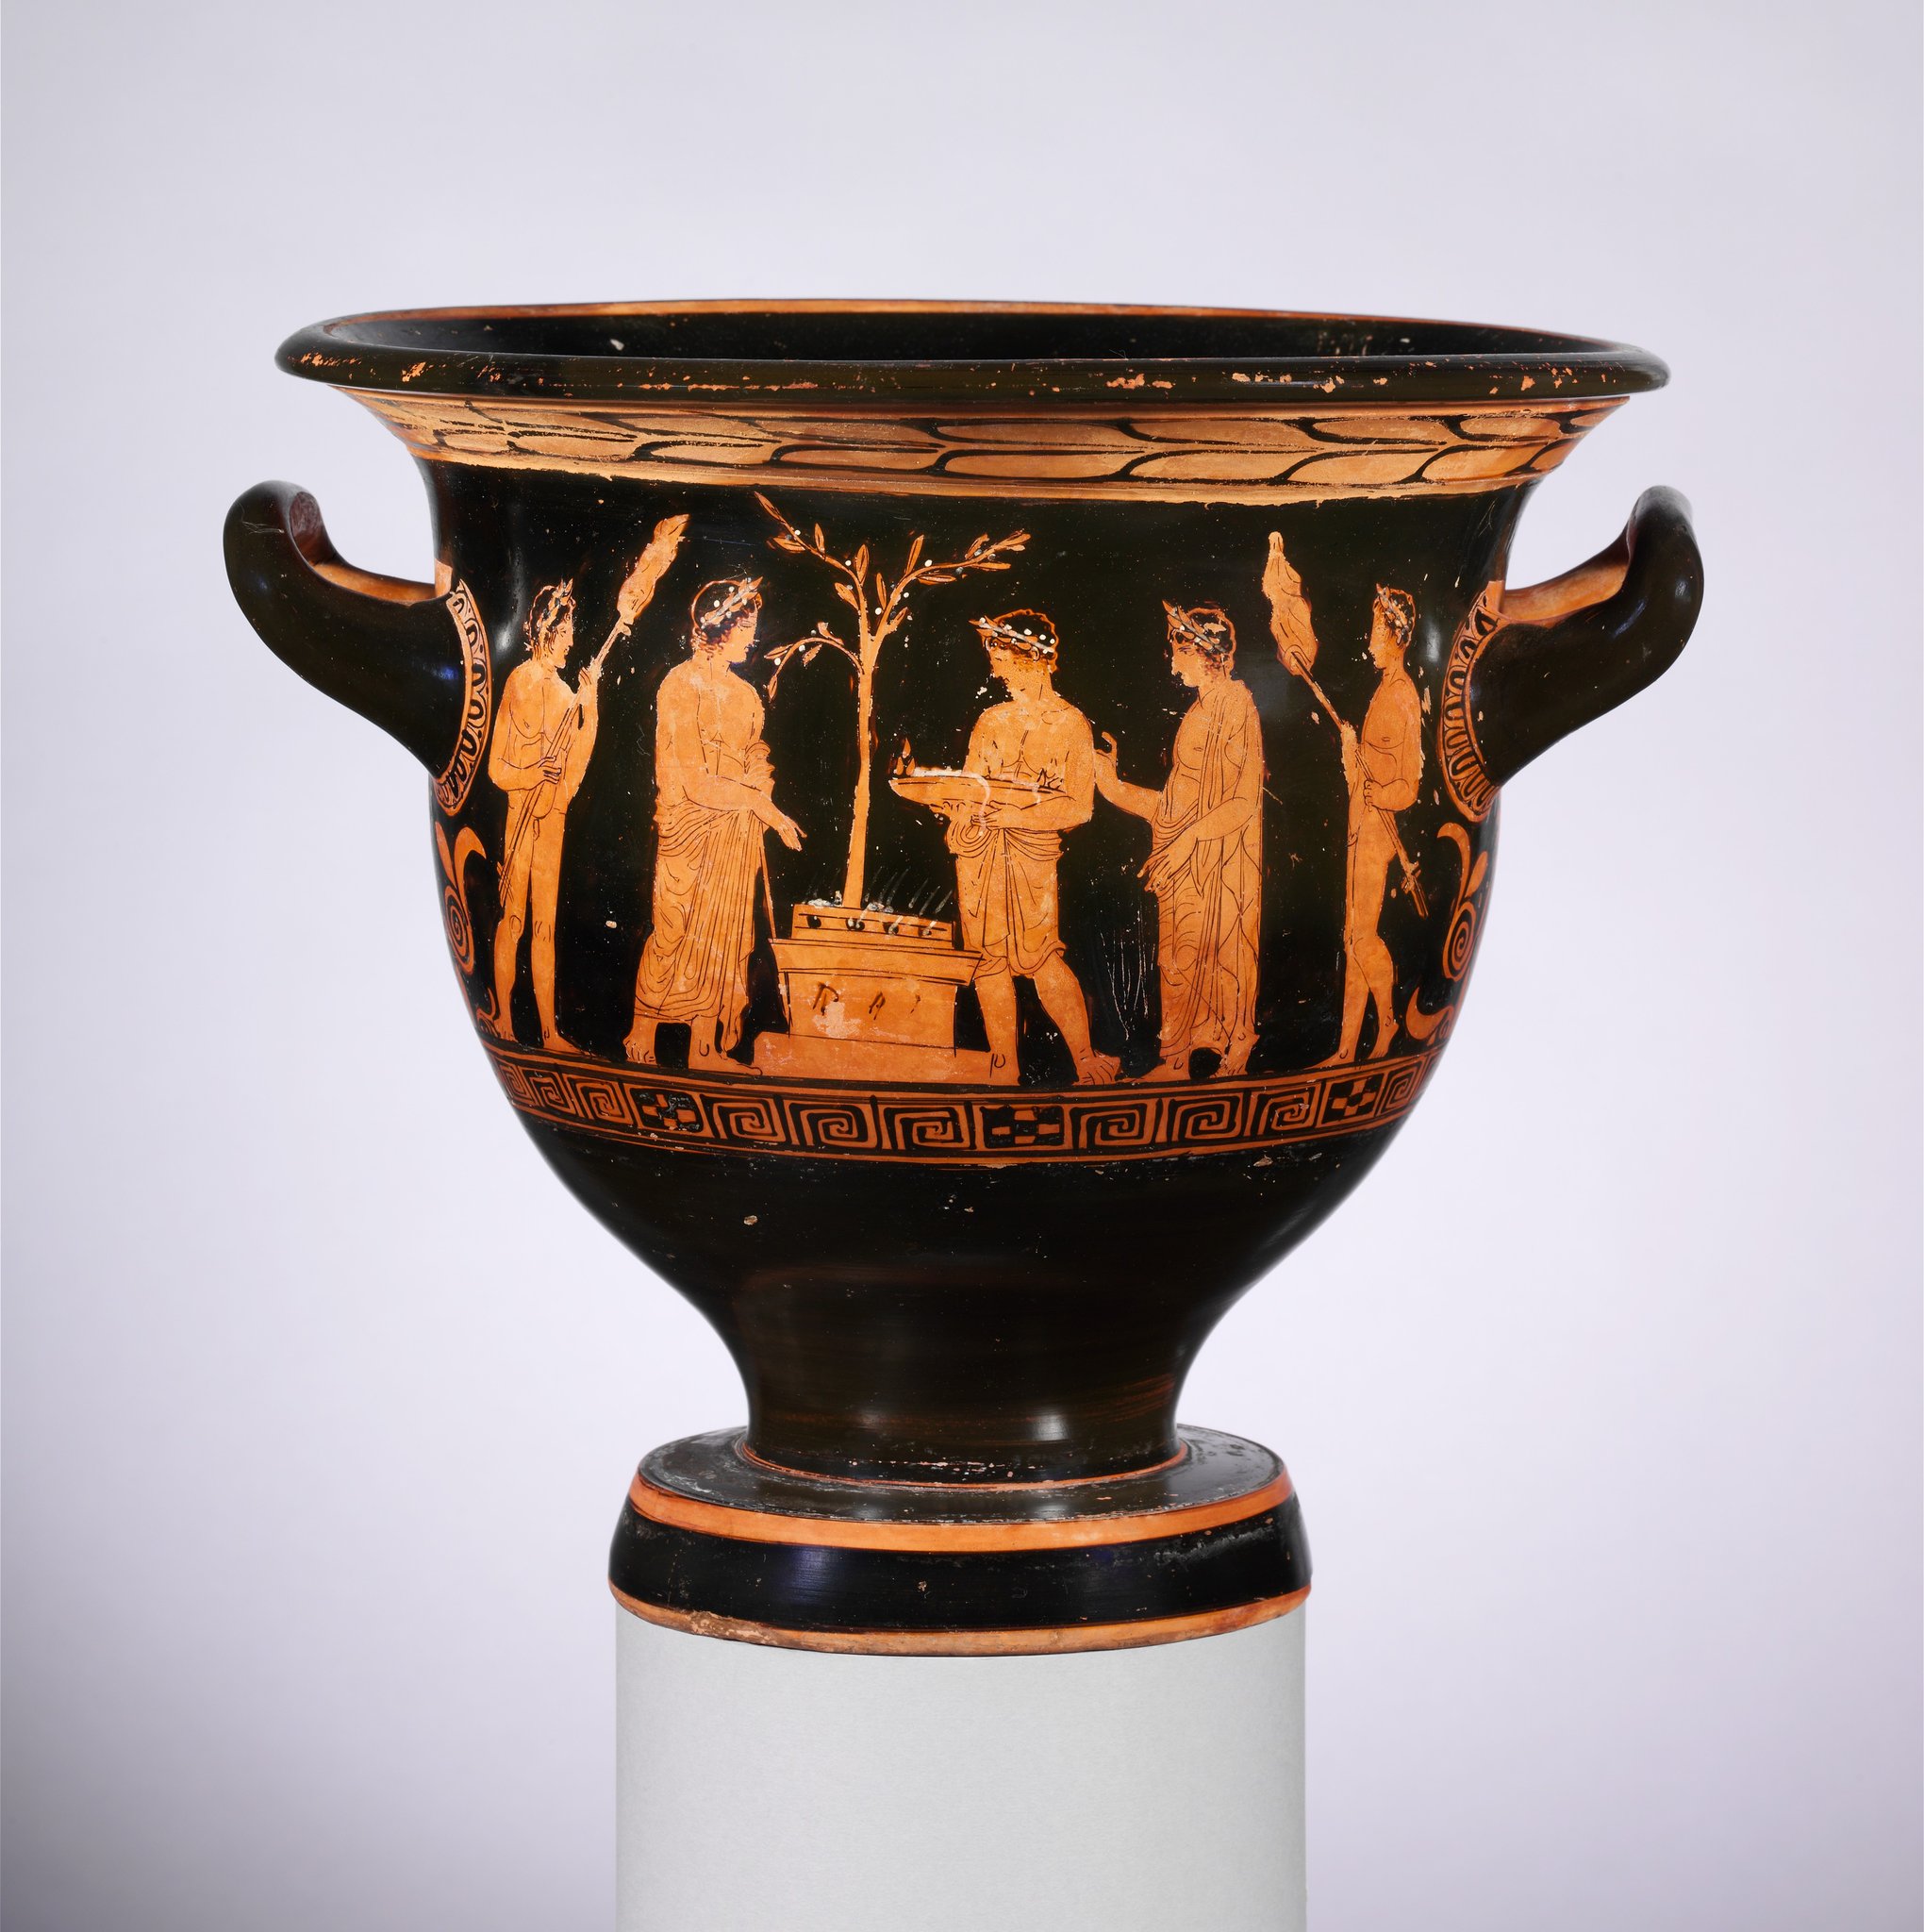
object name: bell krater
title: Terracotta bell-krater (bowl for mixing wine and water)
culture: greek, attic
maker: nikias painter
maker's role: artist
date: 434-401 BCE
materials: terracotta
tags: altars,men